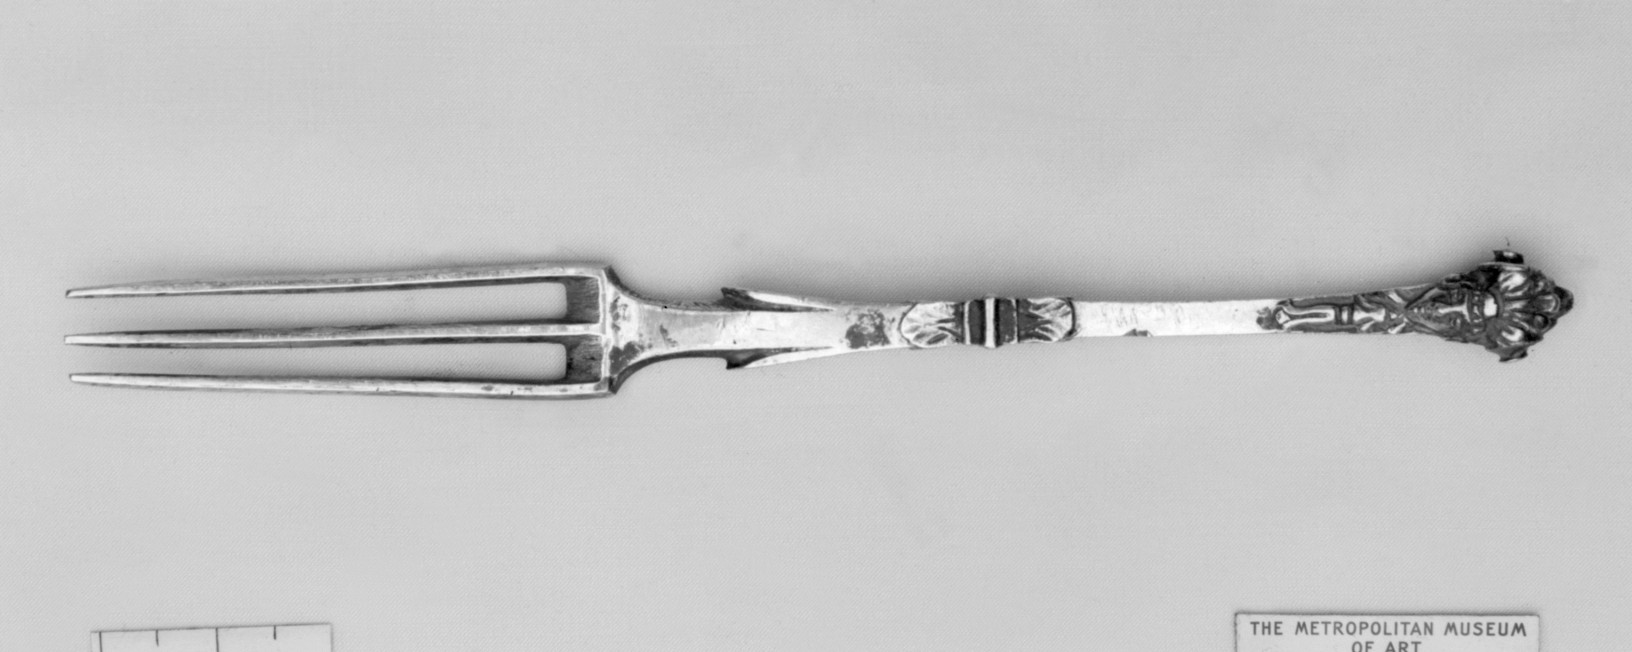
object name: fork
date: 1601-1700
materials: silver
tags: heads